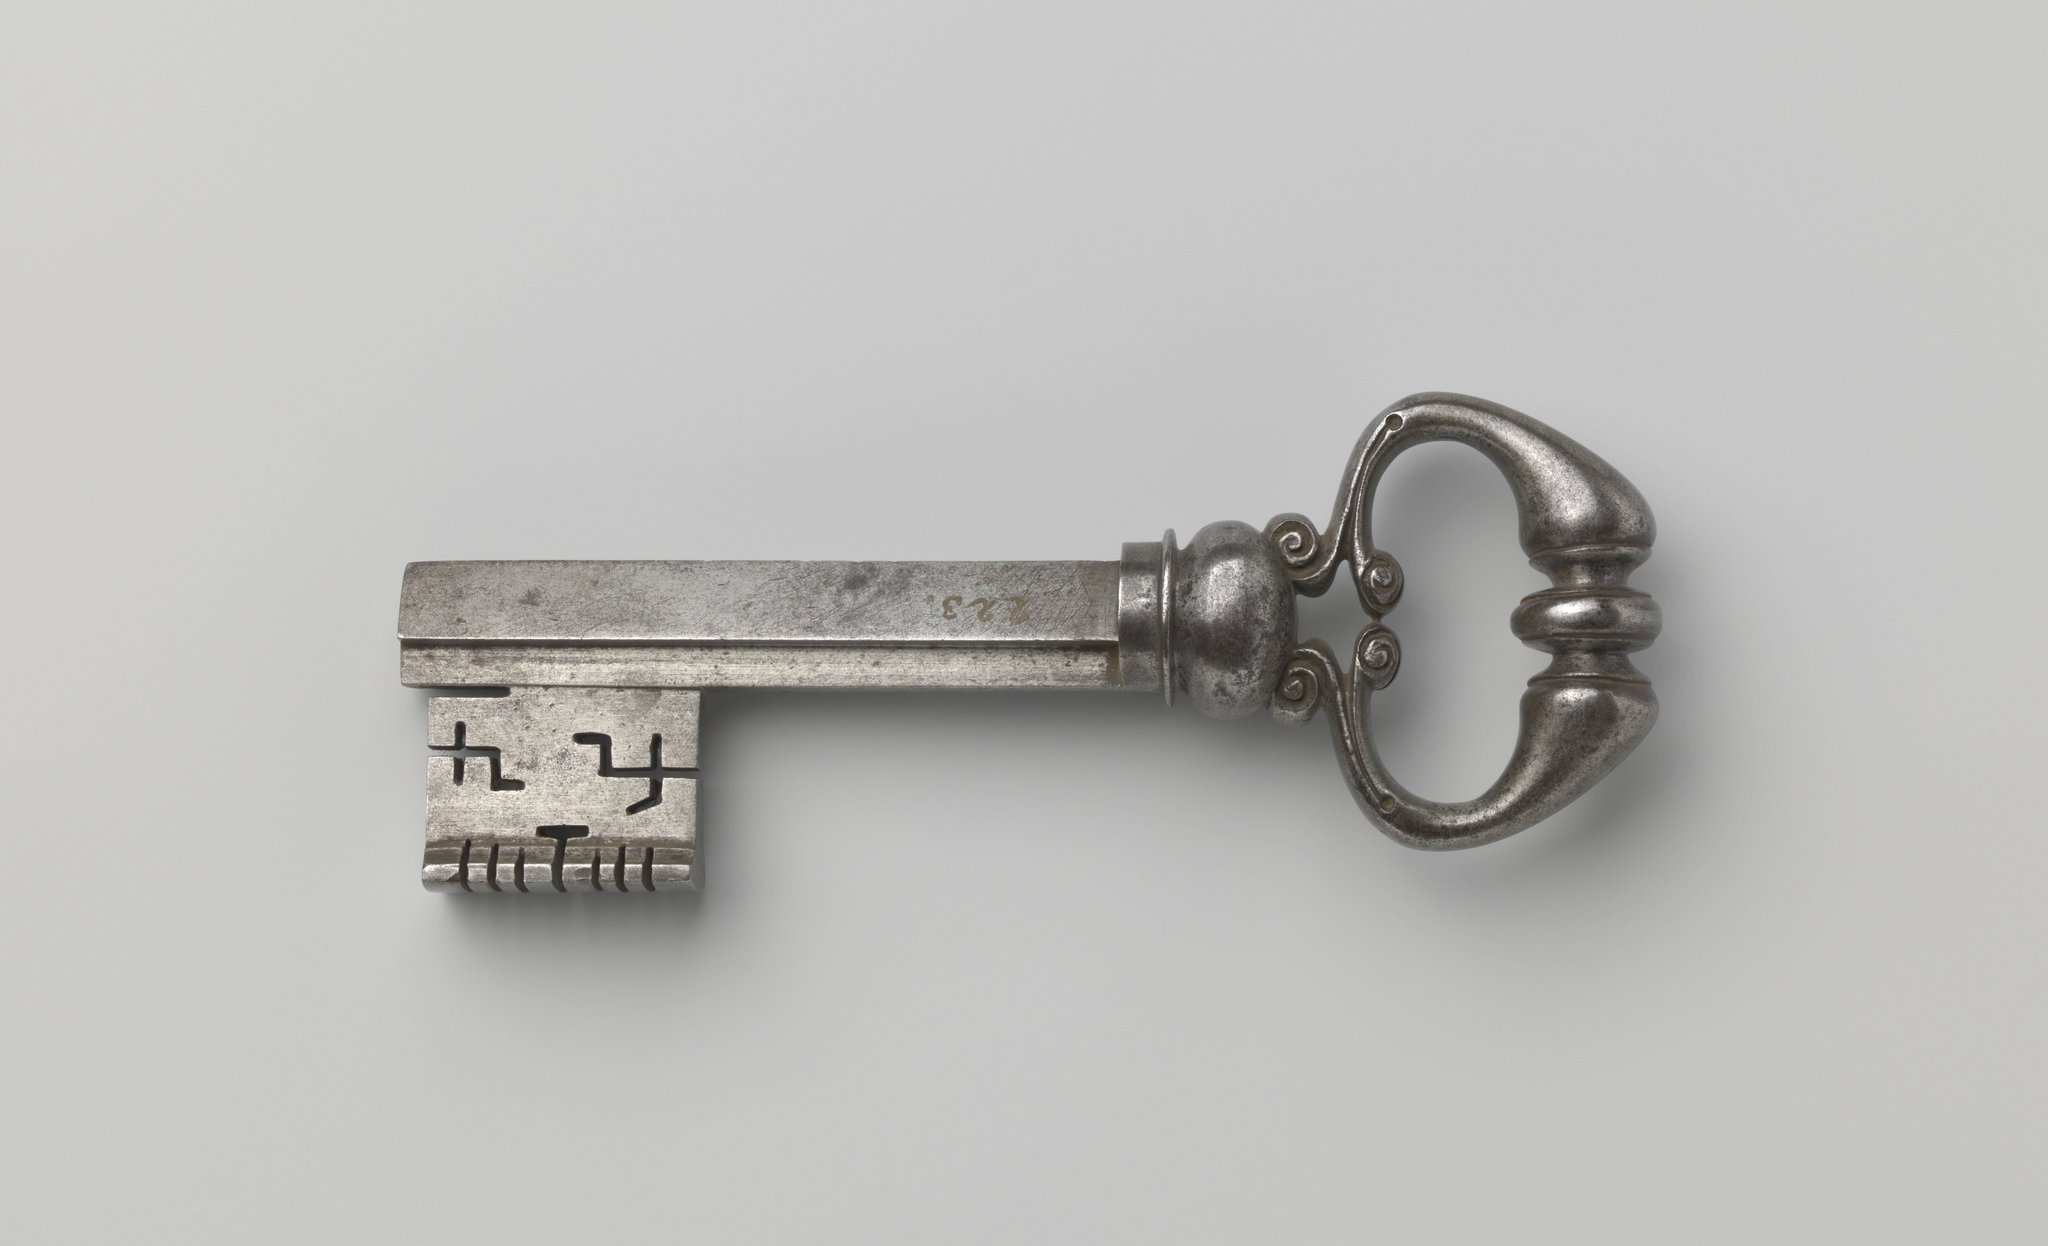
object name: key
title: Sleutel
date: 1600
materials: iron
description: Sleutel waarvan het oog bestaat uit twee naar elkaar toegewende C-voluten, die zich onderaan splitsen en bovenaan in een uivormige verdikking eindigen, een schijf tussen zich insluitend. De voluten zijn geplaatst op een bolvormig kapiteel. De geboorde schacht is driehoekig.